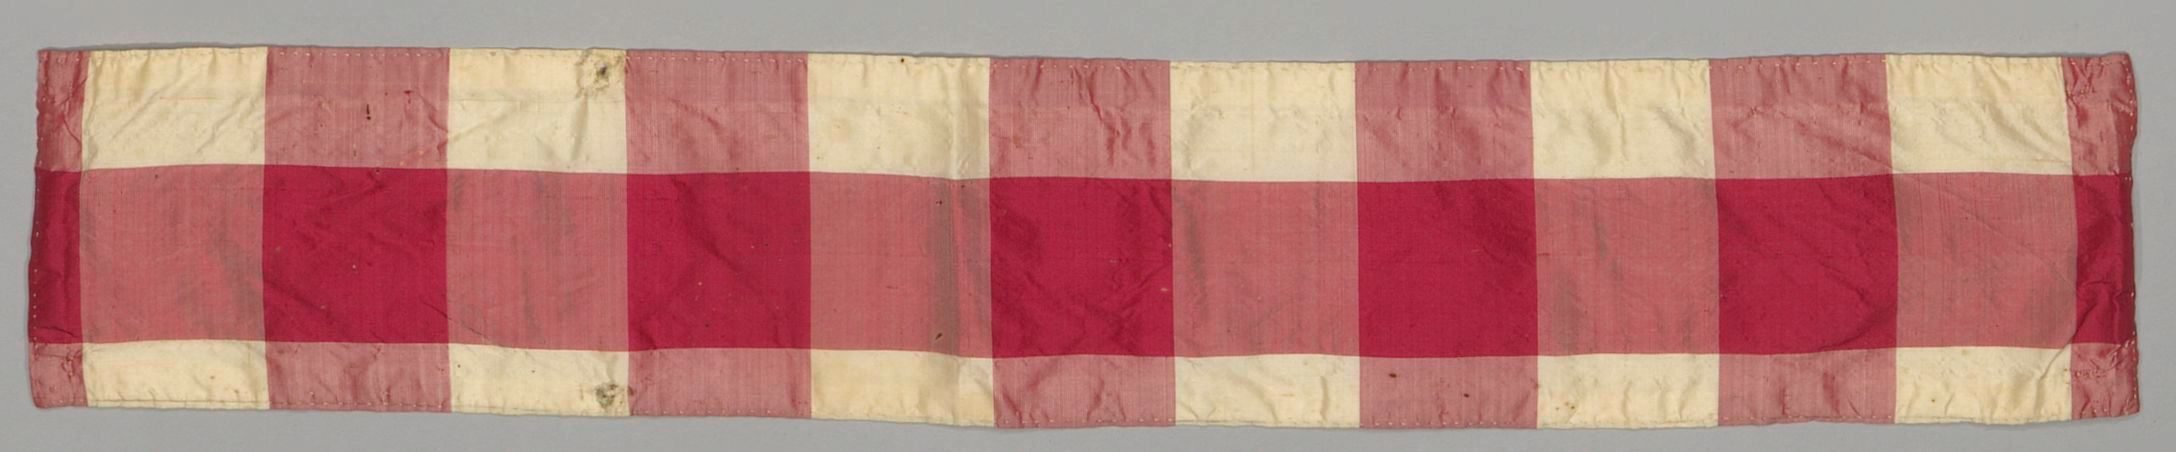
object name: tieback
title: Embrasse van rood-wit geblokte zijde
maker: Anonymous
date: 1776-1800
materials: linen, silk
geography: northern netherlands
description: Embrasse van rood-wit geblokte zijde, gevoerd met wit linnen en met twee stel metalen haken en ogen.